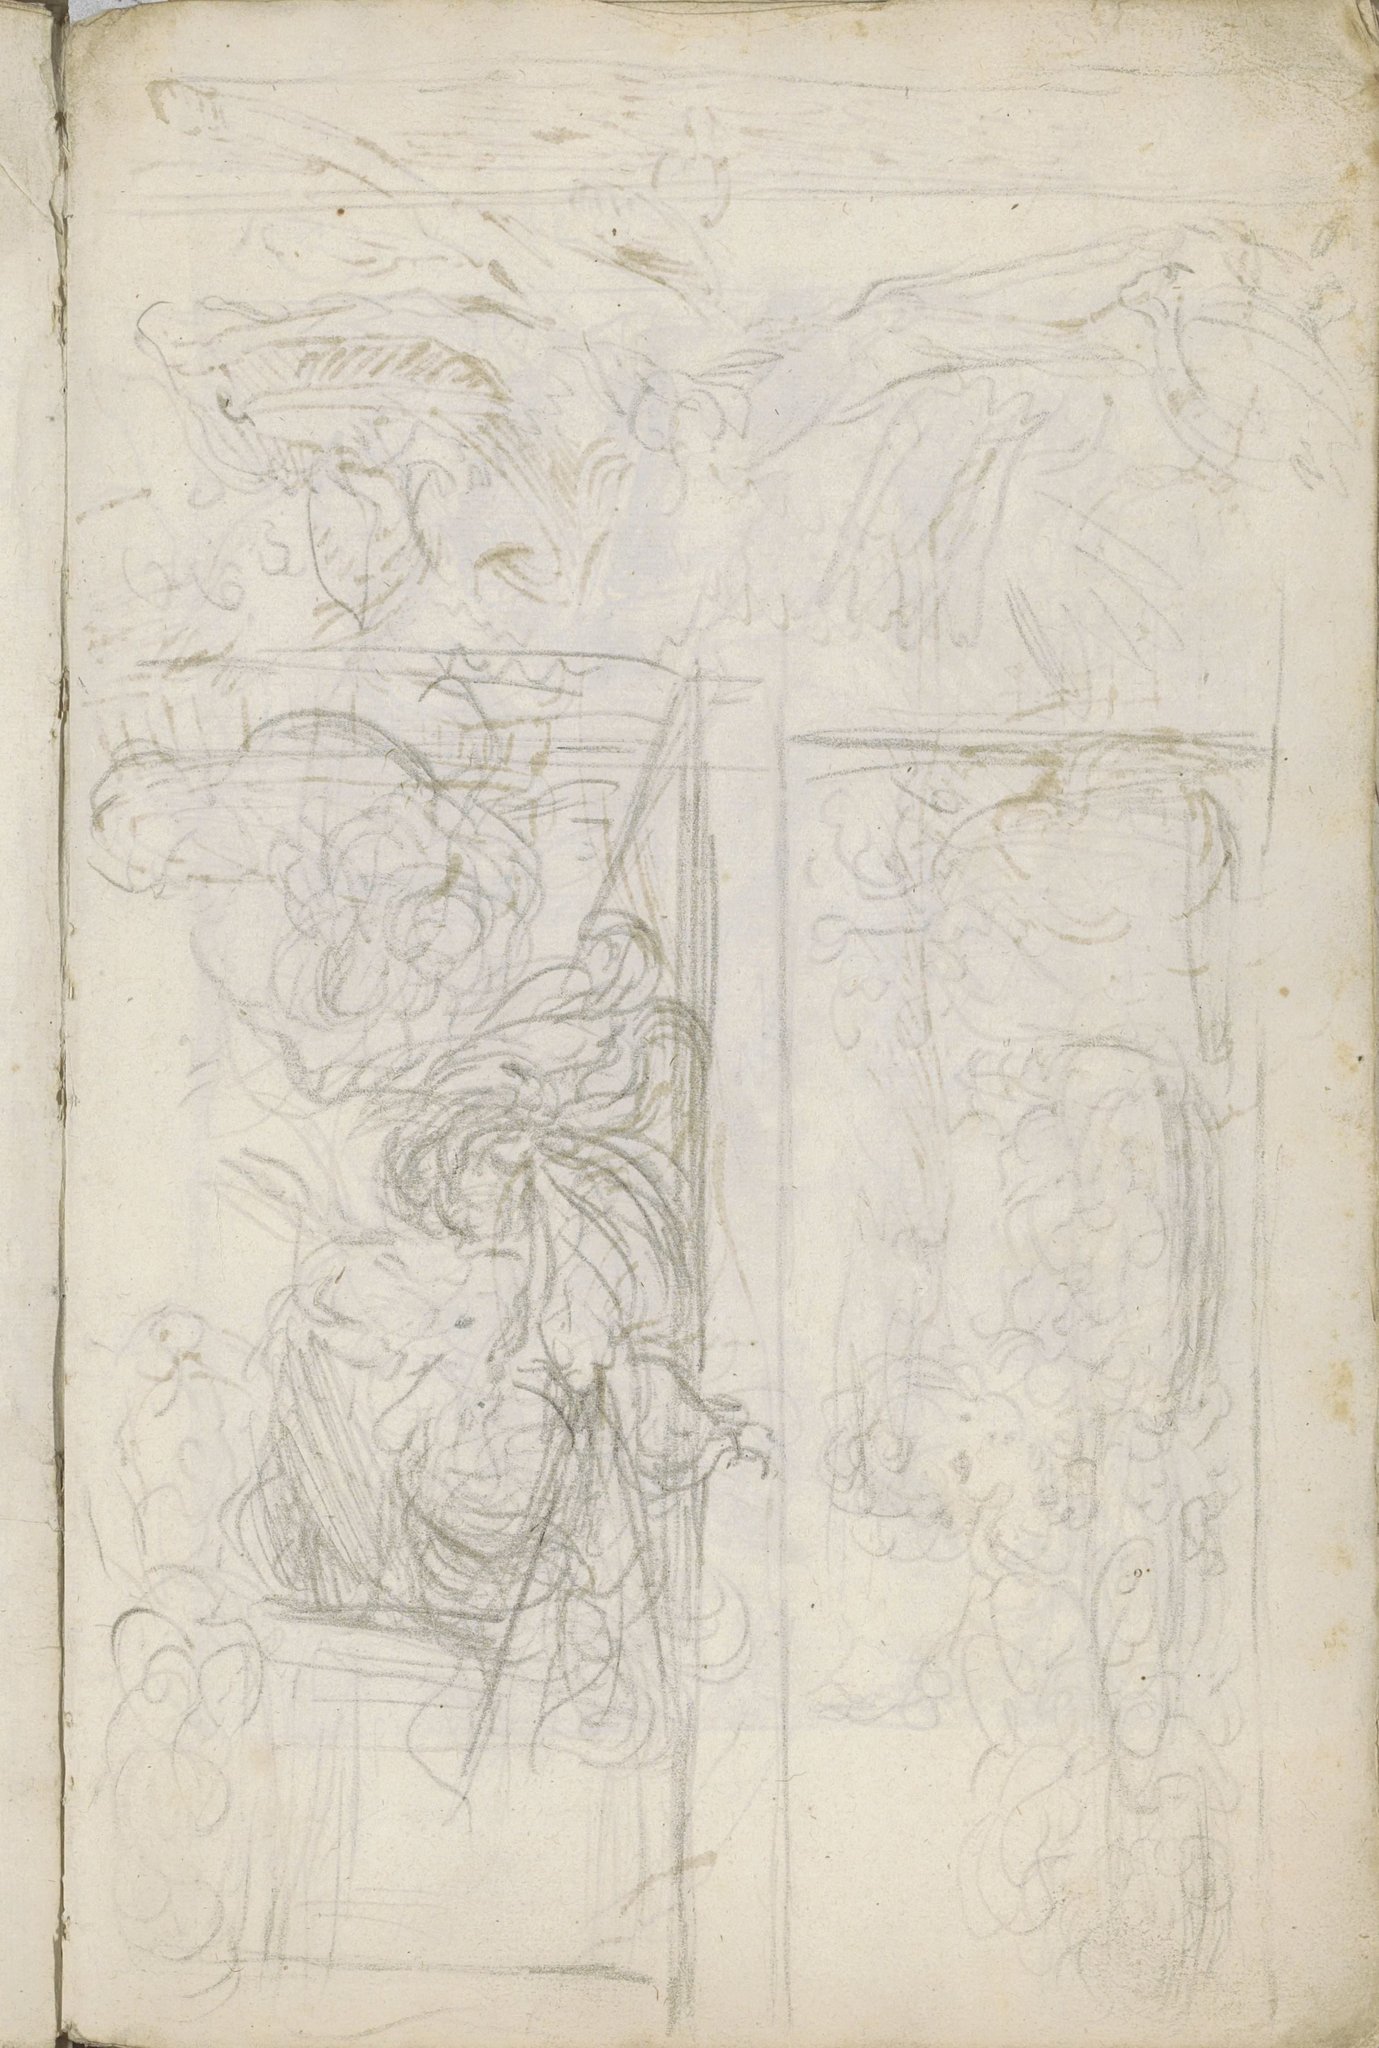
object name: sketchbook leaf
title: Studieblad met takken en stillevens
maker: paul de vos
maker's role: draughtsman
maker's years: 1595-1678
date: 1605-1678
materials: chalk, paper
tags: trees (+ branch, stick), still life of related objects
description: Blad 4 recto uit een schetsboek met 15 bladen.